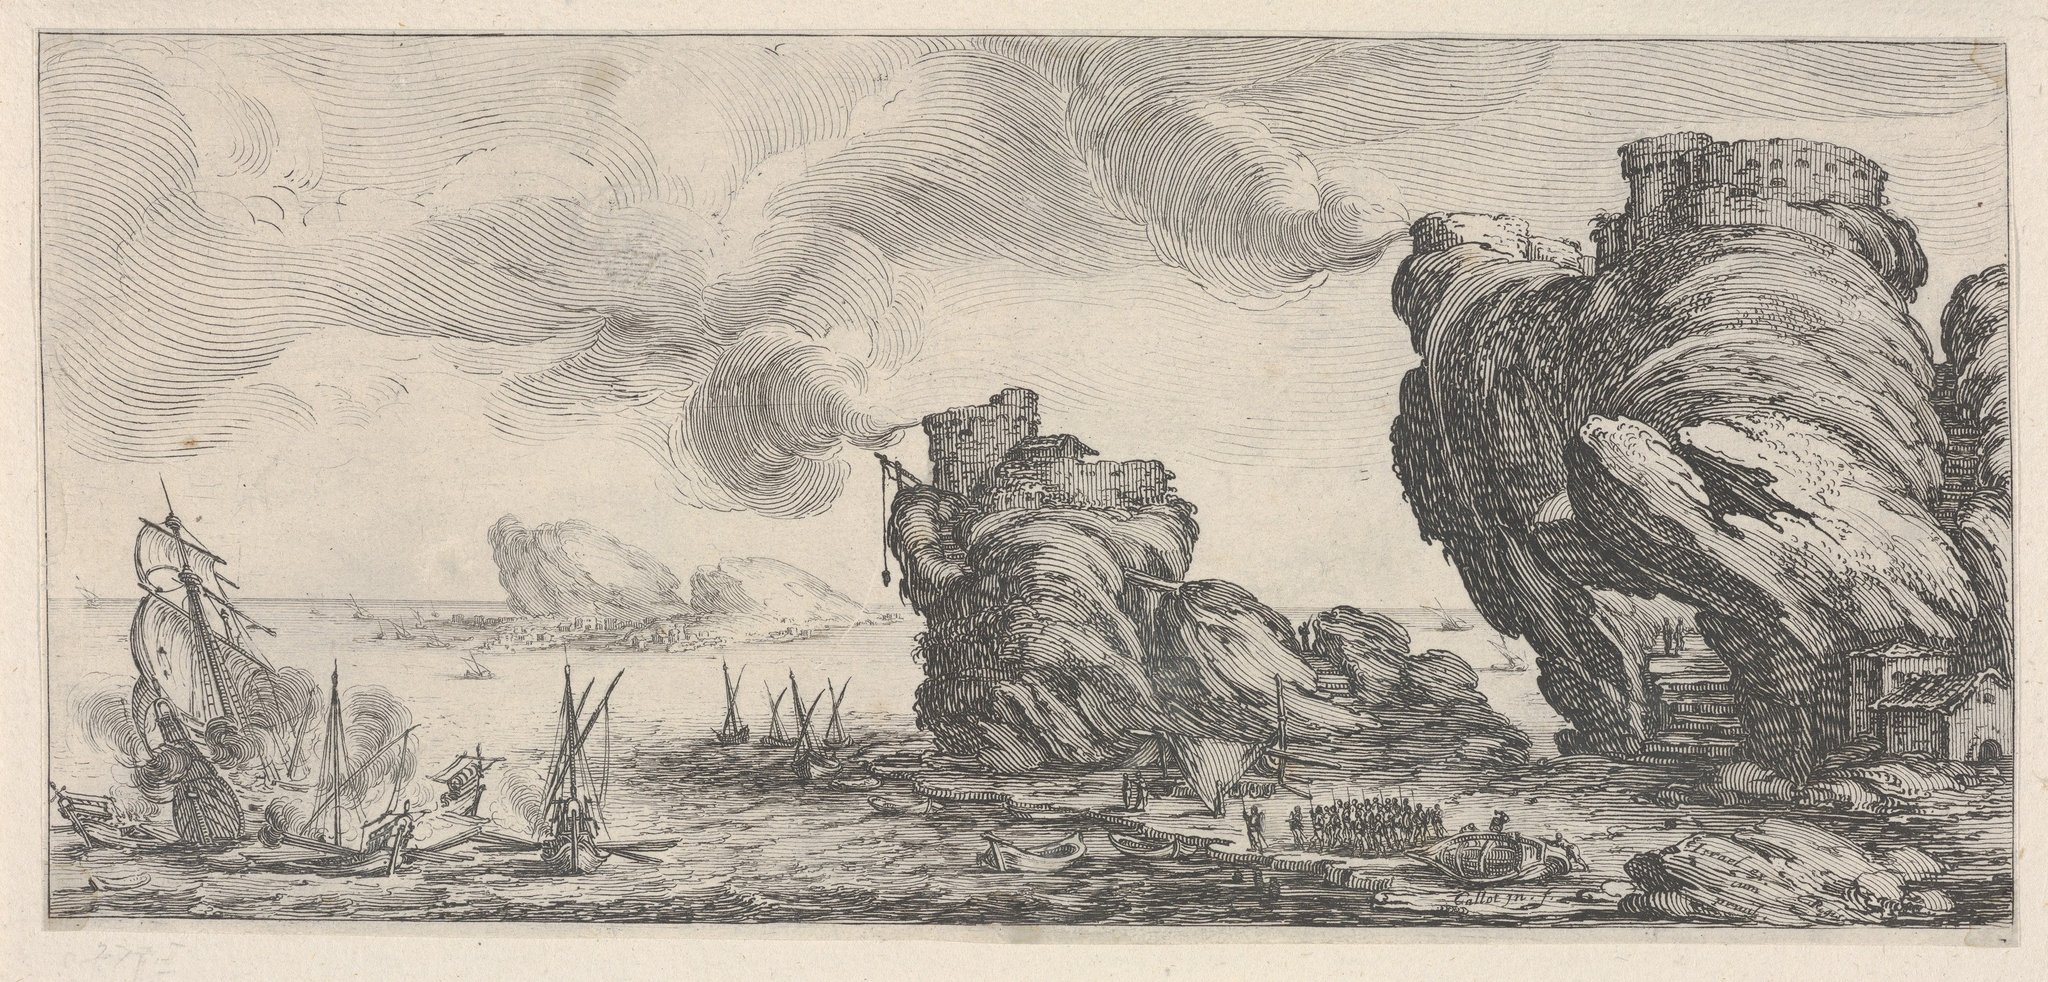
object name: print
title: Naval battle with ruined ship and smoking battlements, from "Italian landscapes" (Diverse vedute designate in Fiorenza / Paysages italiens)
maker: jacques callot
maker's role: artist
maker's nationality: french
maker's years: 1592-1635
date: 1618-1635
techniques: etching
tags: boats,ships